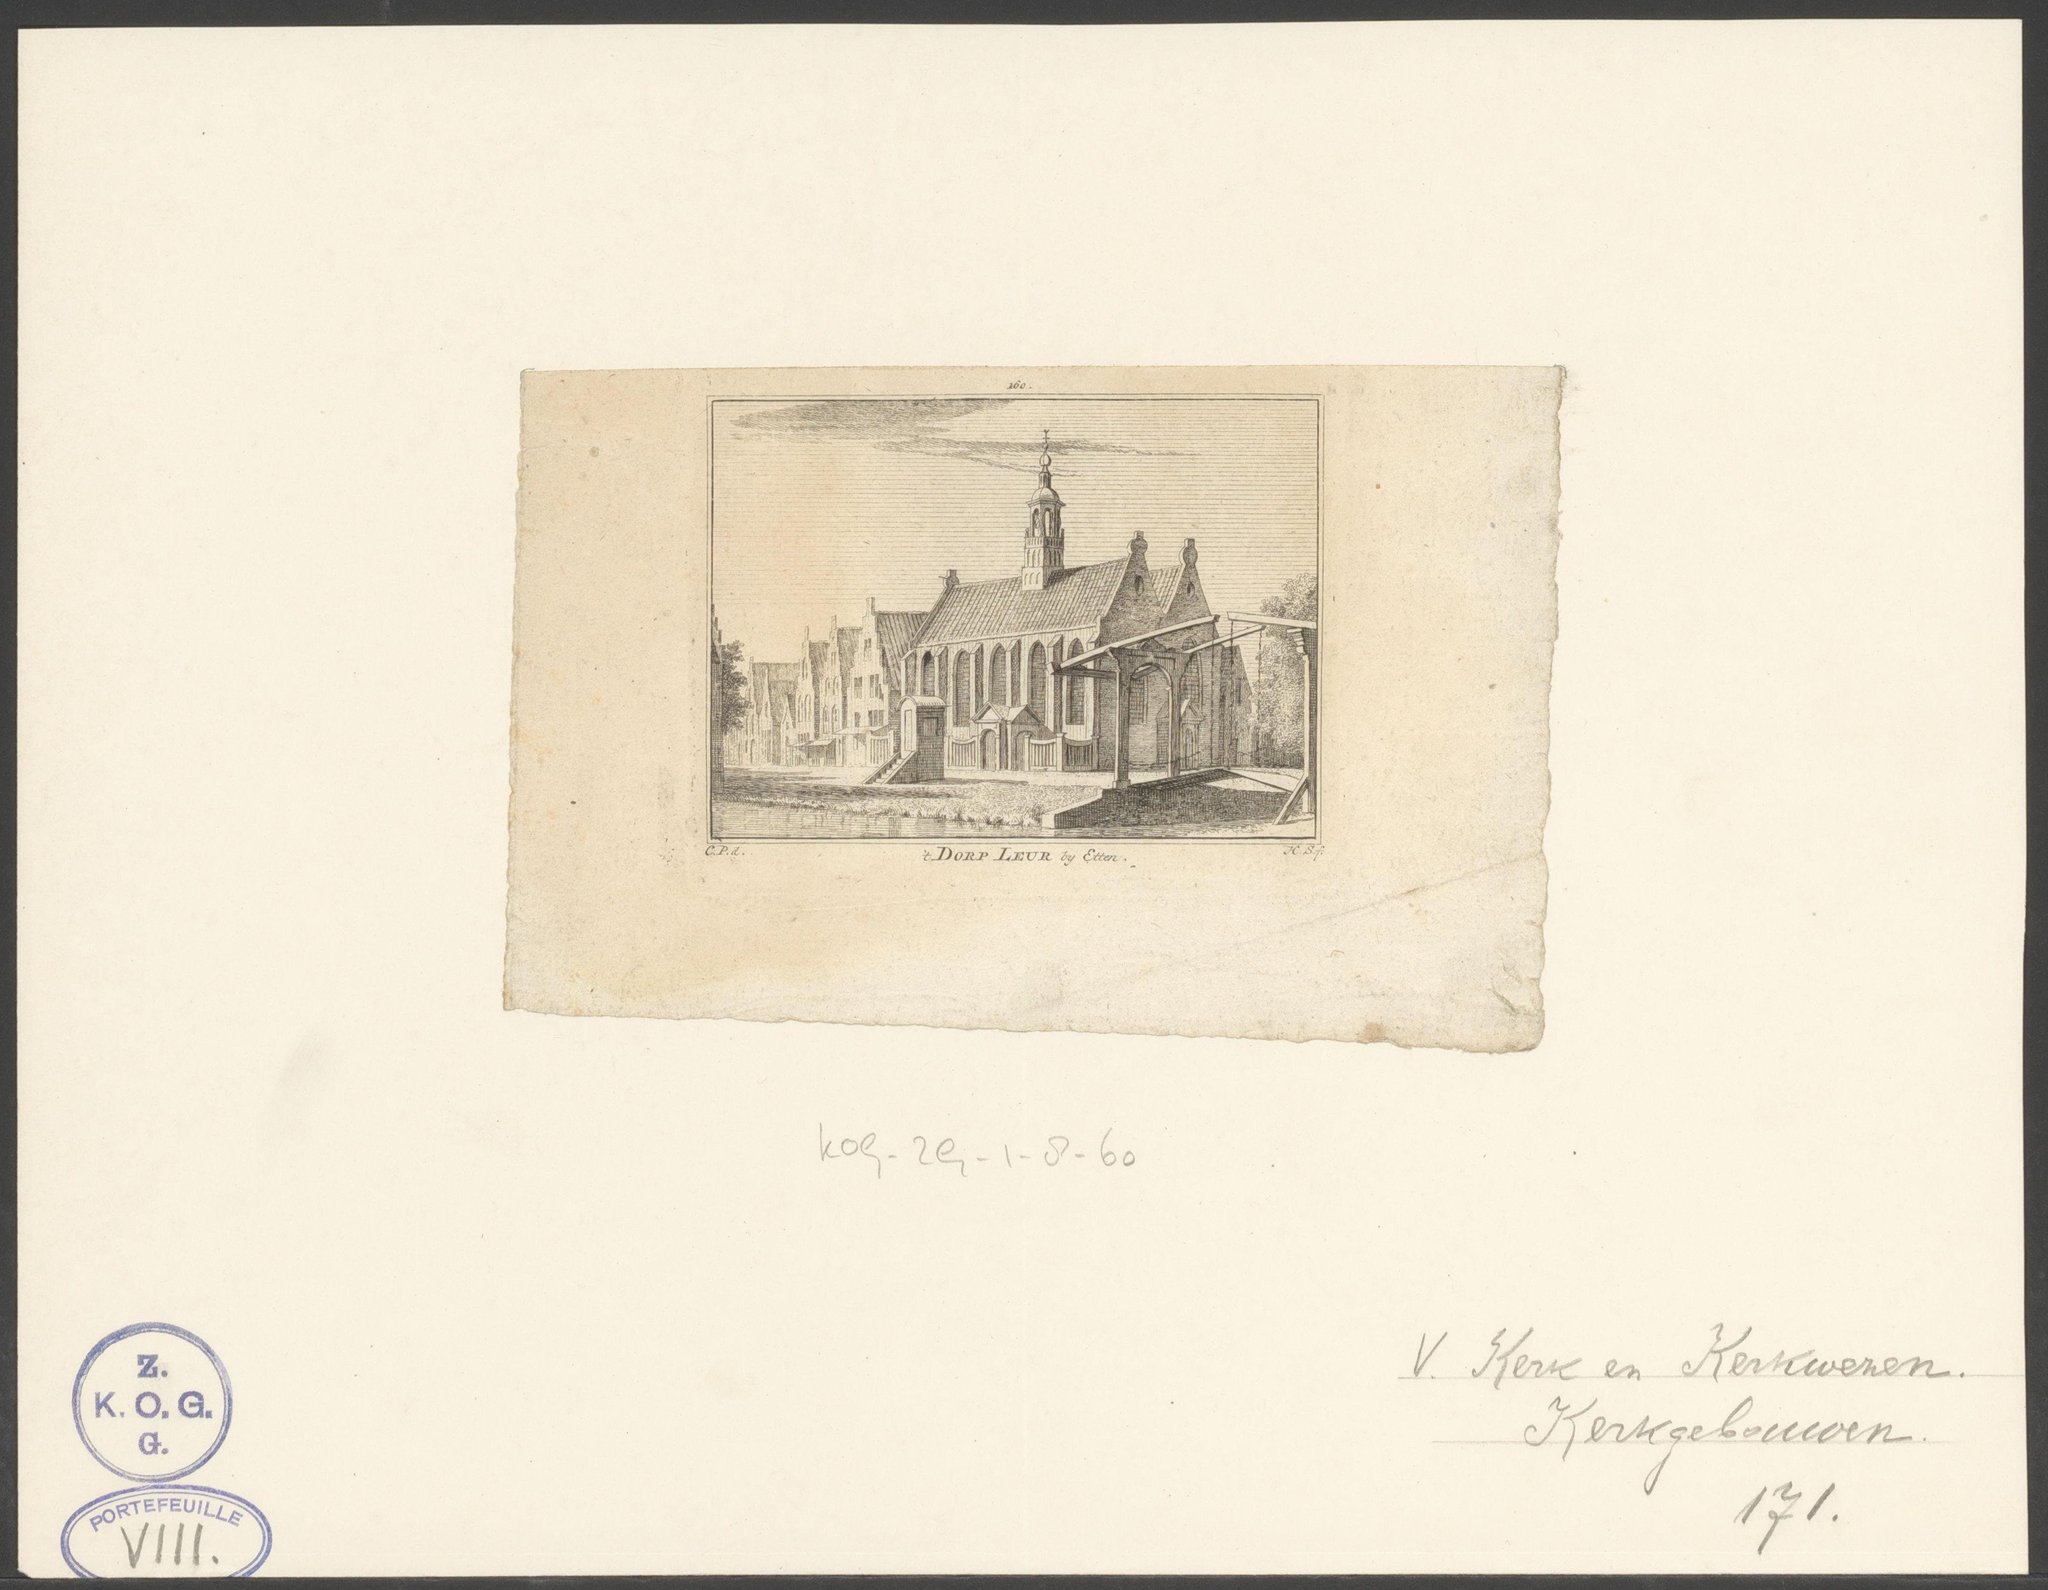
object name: print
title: 't Dorp Leur by Etten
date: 1746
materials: paper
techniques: engraving, etching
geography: netherlands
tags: church (exterior)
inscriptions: collector's mark, collector's mark: Lugt 1641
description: Gezicht op de kerk in het dorp Leur bij Etten. Onderste helft van een blad waarop oorspronkelijk twee voorstellingen waren gedrukt. Onderwerpsrubrieken binnen de Atlas Zeden en Gewoonten: Kerk en kerkwezen & Armwezen en liefdadige instellingen; Kerkgebouwen elders. F-L.